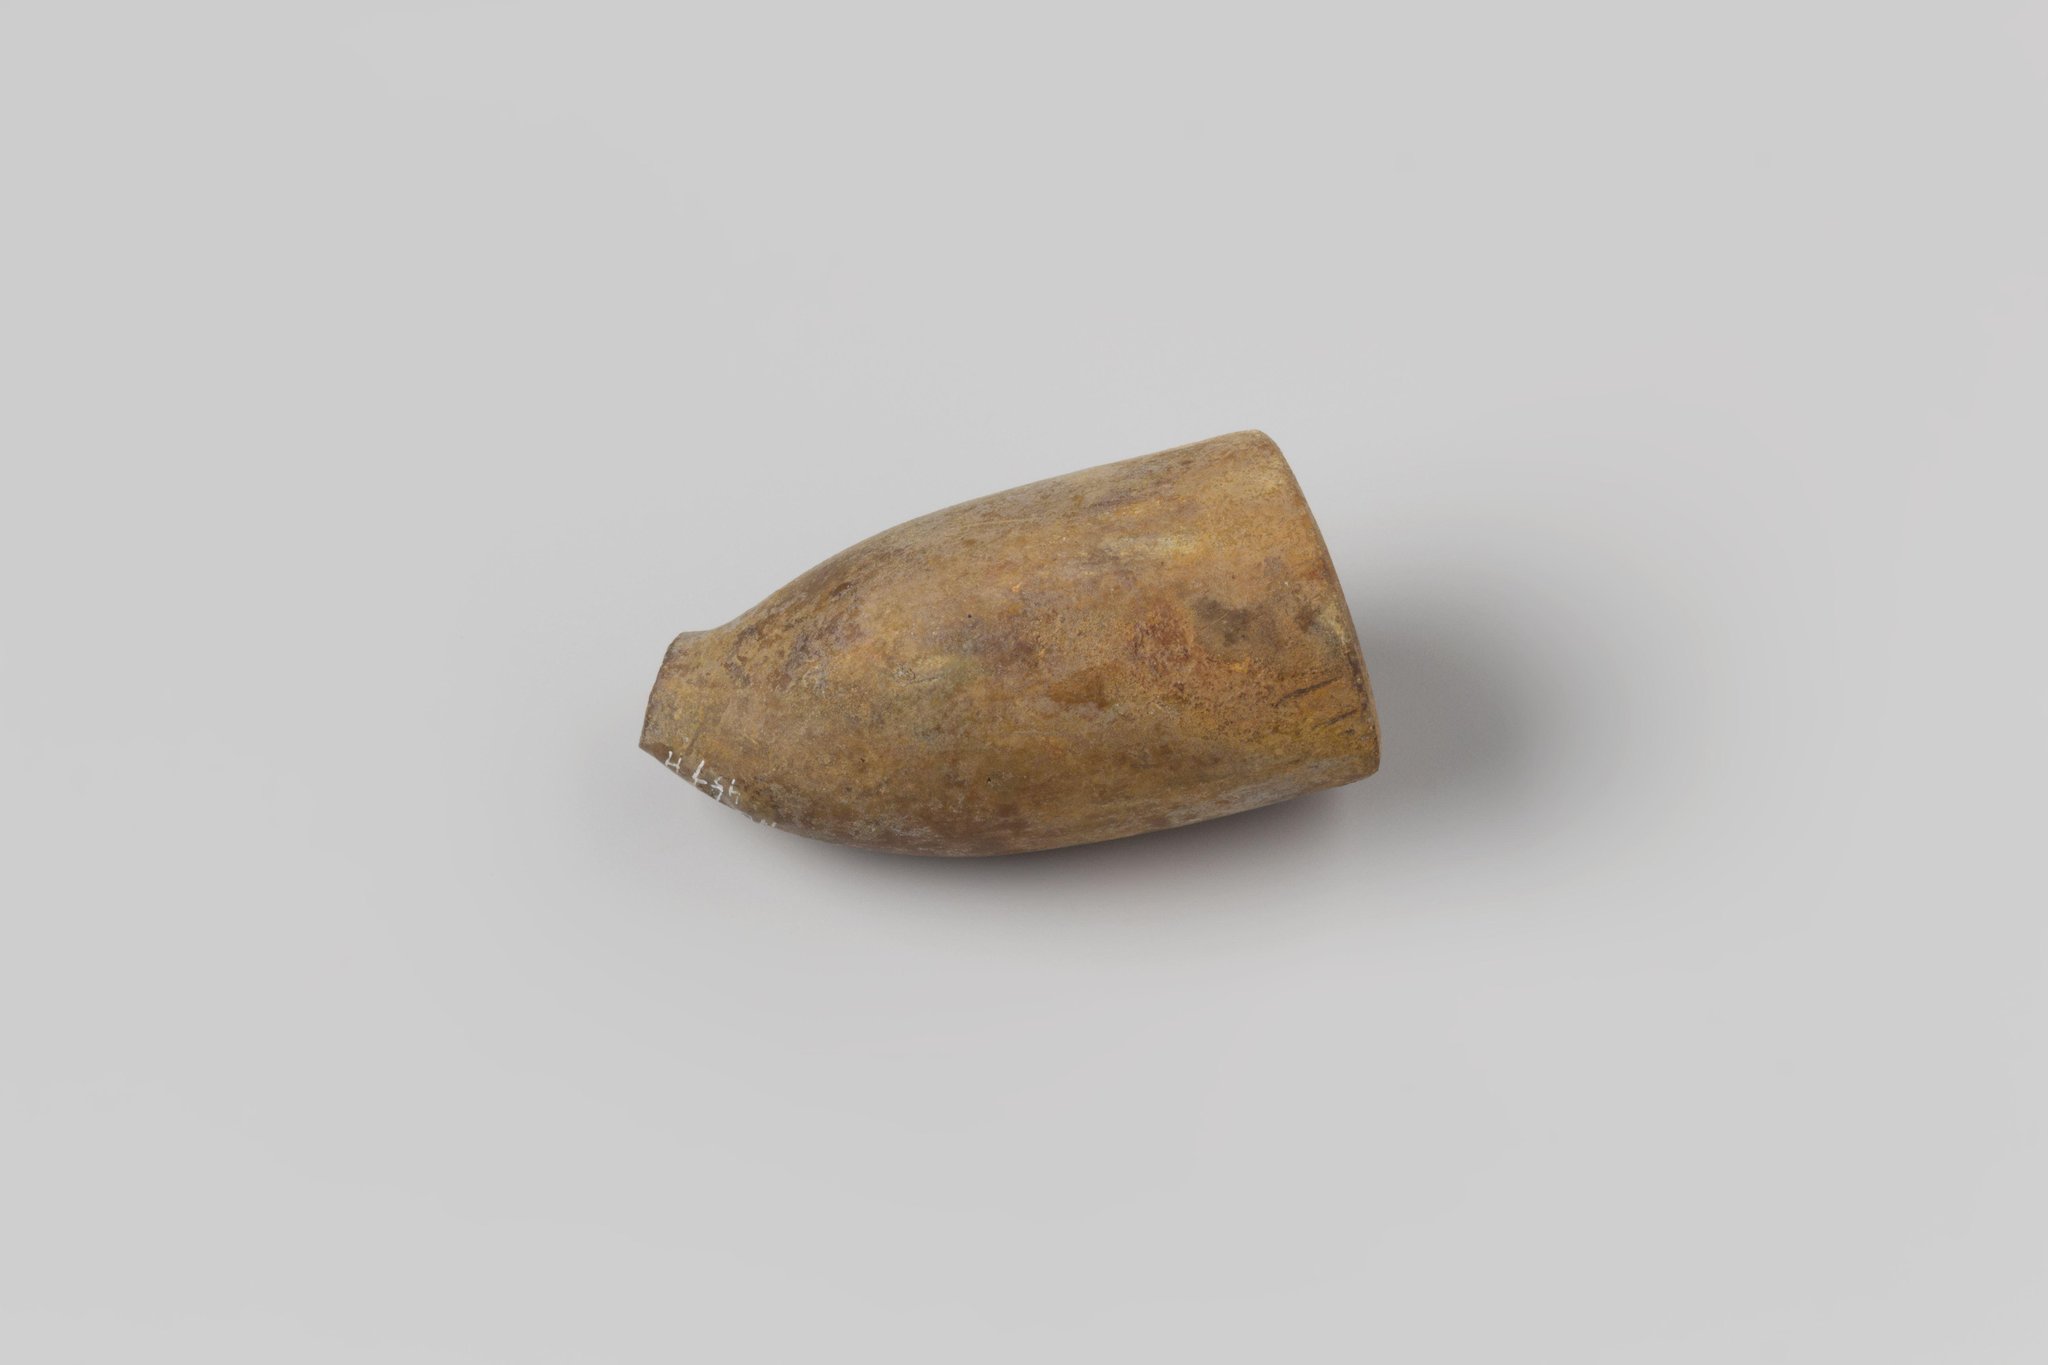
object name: pipe bowl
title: Pijpenkop uit het wrak van de Oost-Indiëvaarder Hollandia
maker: Anonymous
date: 1700-1743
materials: clay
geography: netherlands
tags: verenigde oostindische compagnie, hollandia (schip), annet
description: Pipe, bowl without heel: stamped decoration.